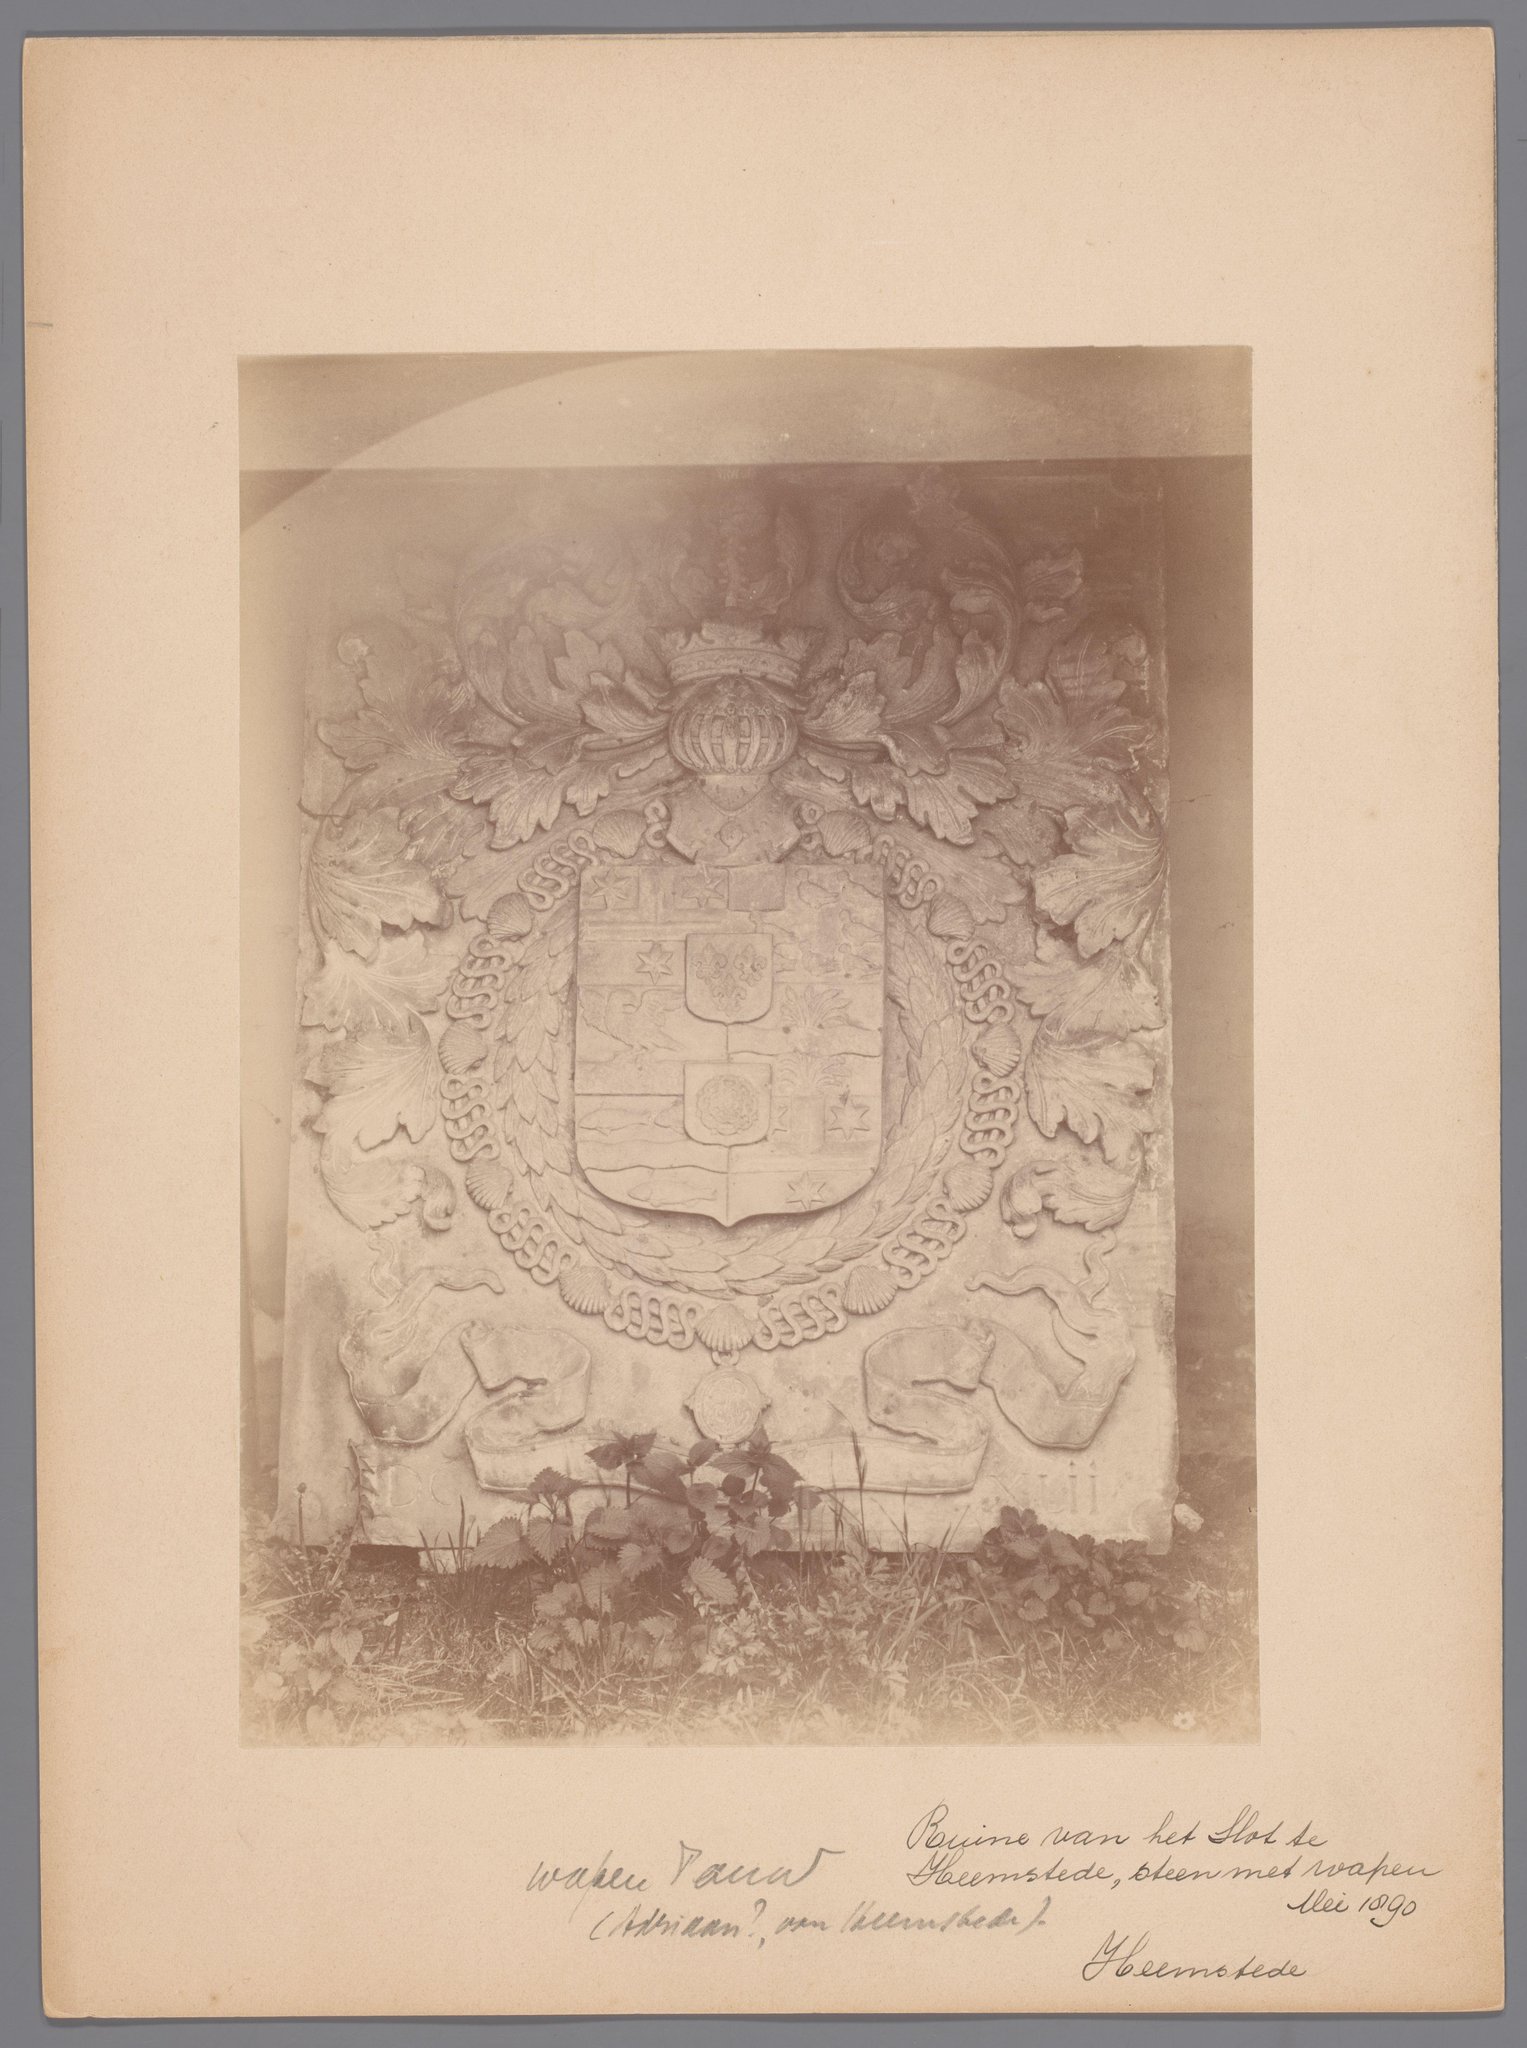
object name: photograph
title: Steen met wapen van de ruïne van het slot te Heemstede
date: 1890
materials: cardboard, photographic support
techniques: albumen print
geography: heemstede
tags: architectural detail, piece of sculpture, reproduction of a piece of sculpture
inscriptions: annotation: ‘Ruine van het slot te Heemstede, steen met wapen/ mei 1890/ vader Touw/ (Adristiaan?, van Heemstede)/ Heemstede’, annotation: ‘Ruine van het slot Heemstede te Heemstede/ steen met wapen/ Mei 1890’